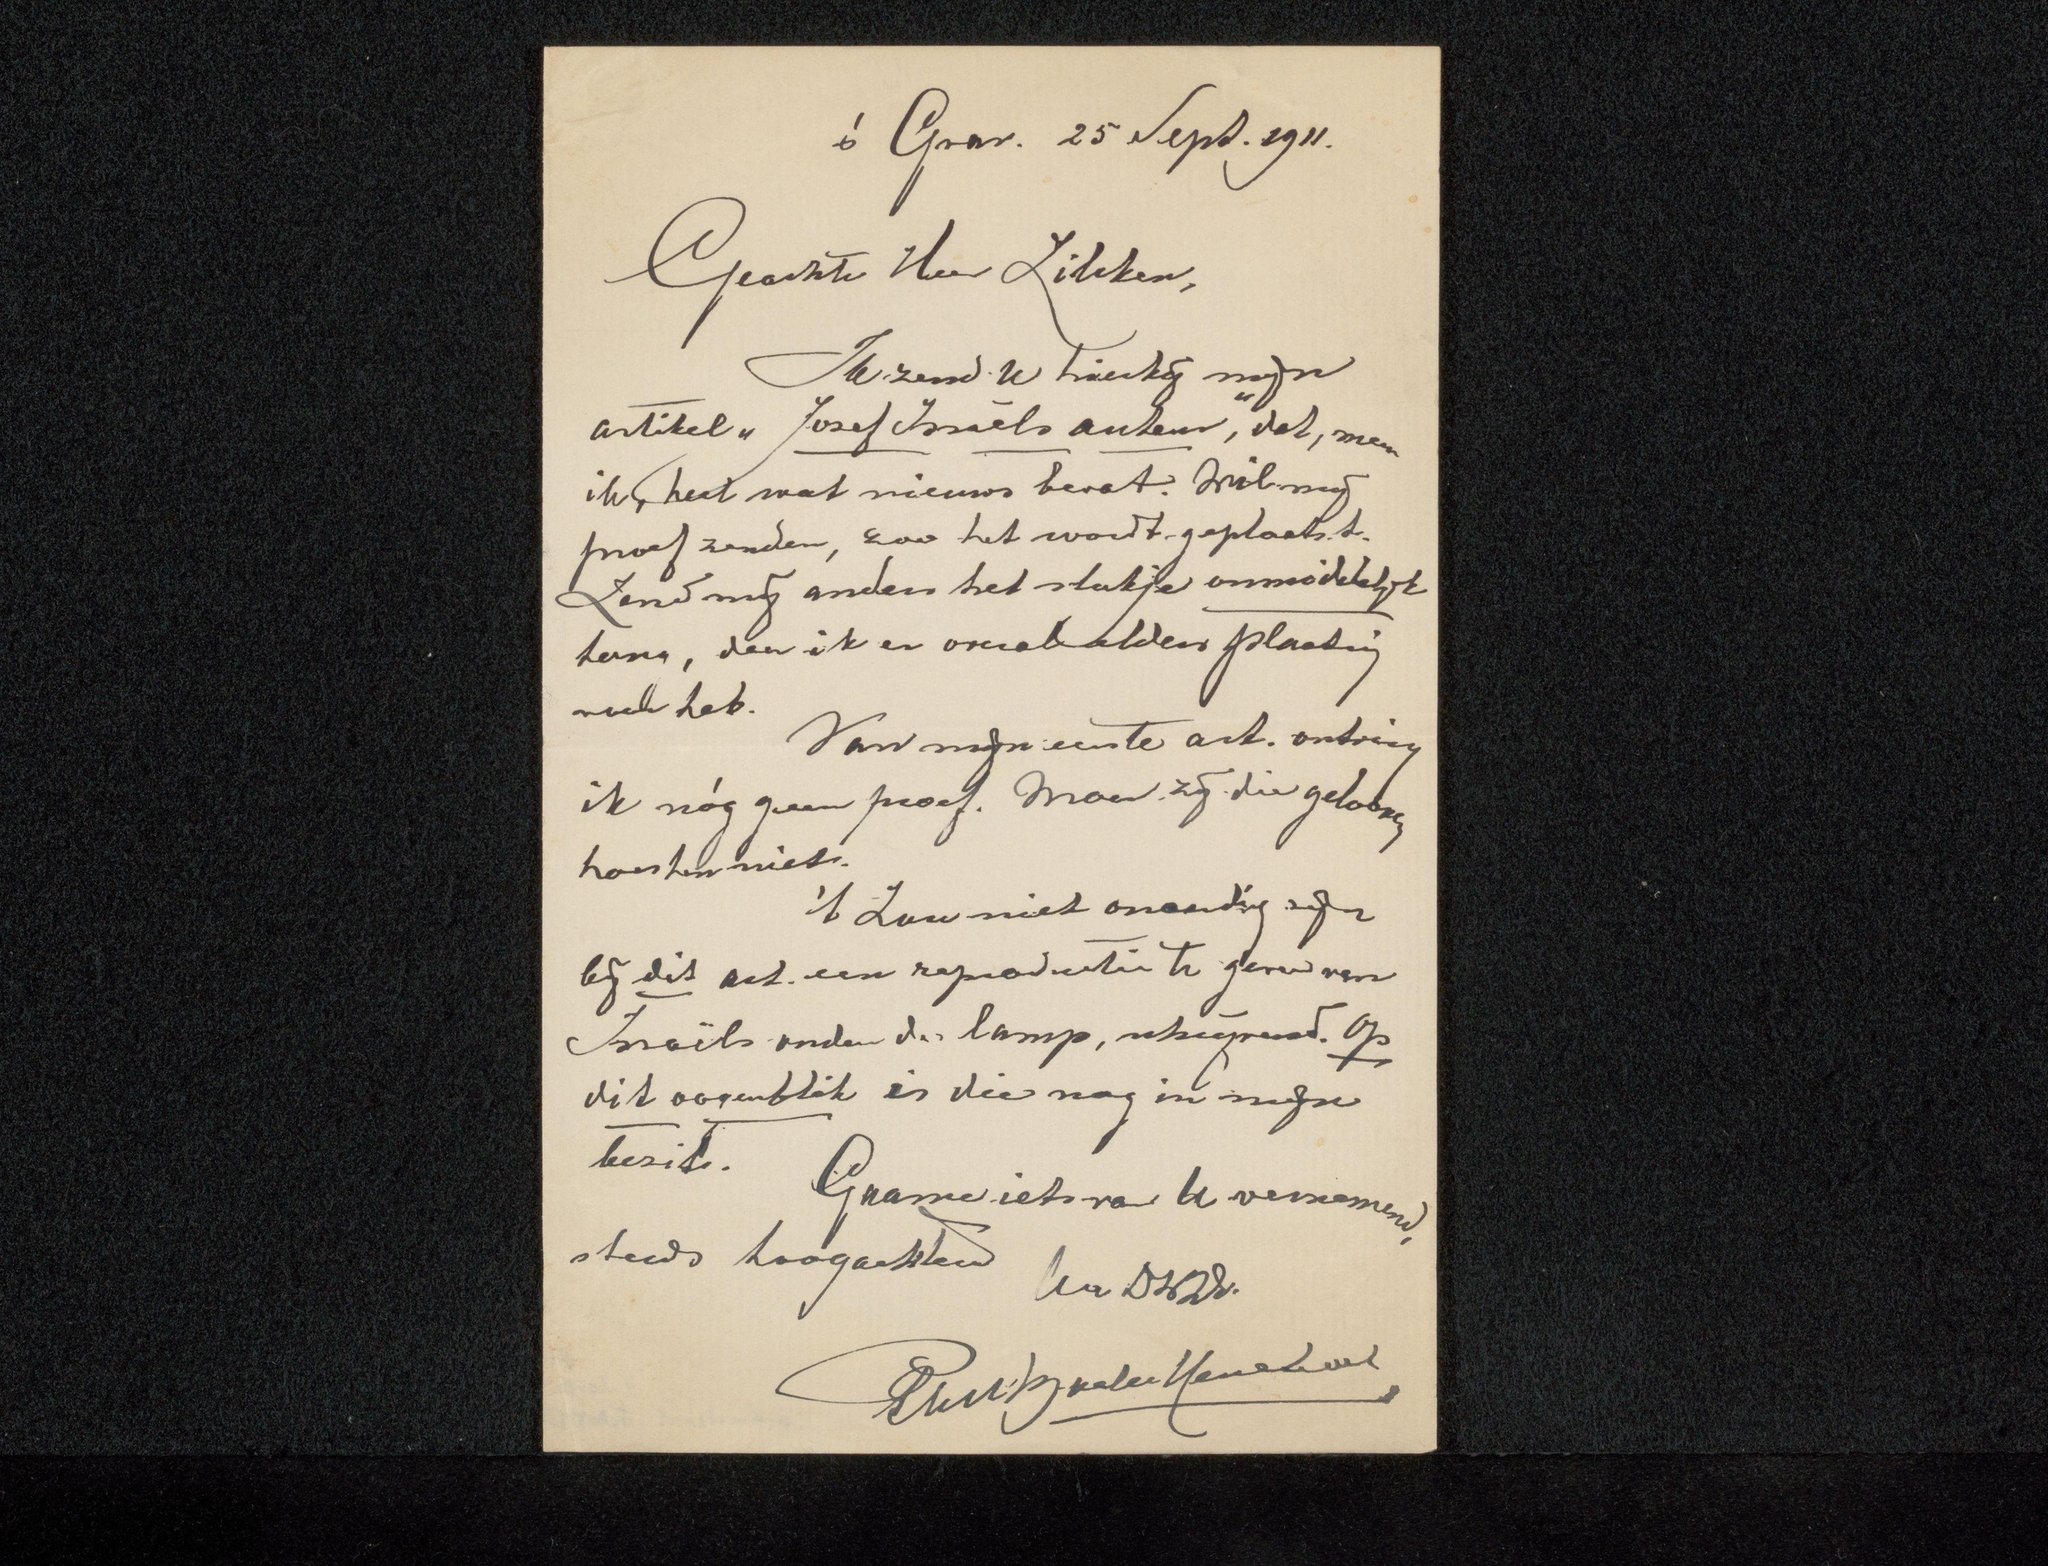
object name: letter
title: Brief aan Philip Zilcken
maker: pieter andreas martin boele van hensbroek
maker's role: publisher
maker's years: 1853-1912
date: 1911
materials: ink, paper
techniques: pen, writing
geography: the hague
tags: print maker, jozef israëls, painter, draughtsman, philip zilcken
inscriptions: collector's mark: ‘RPK’